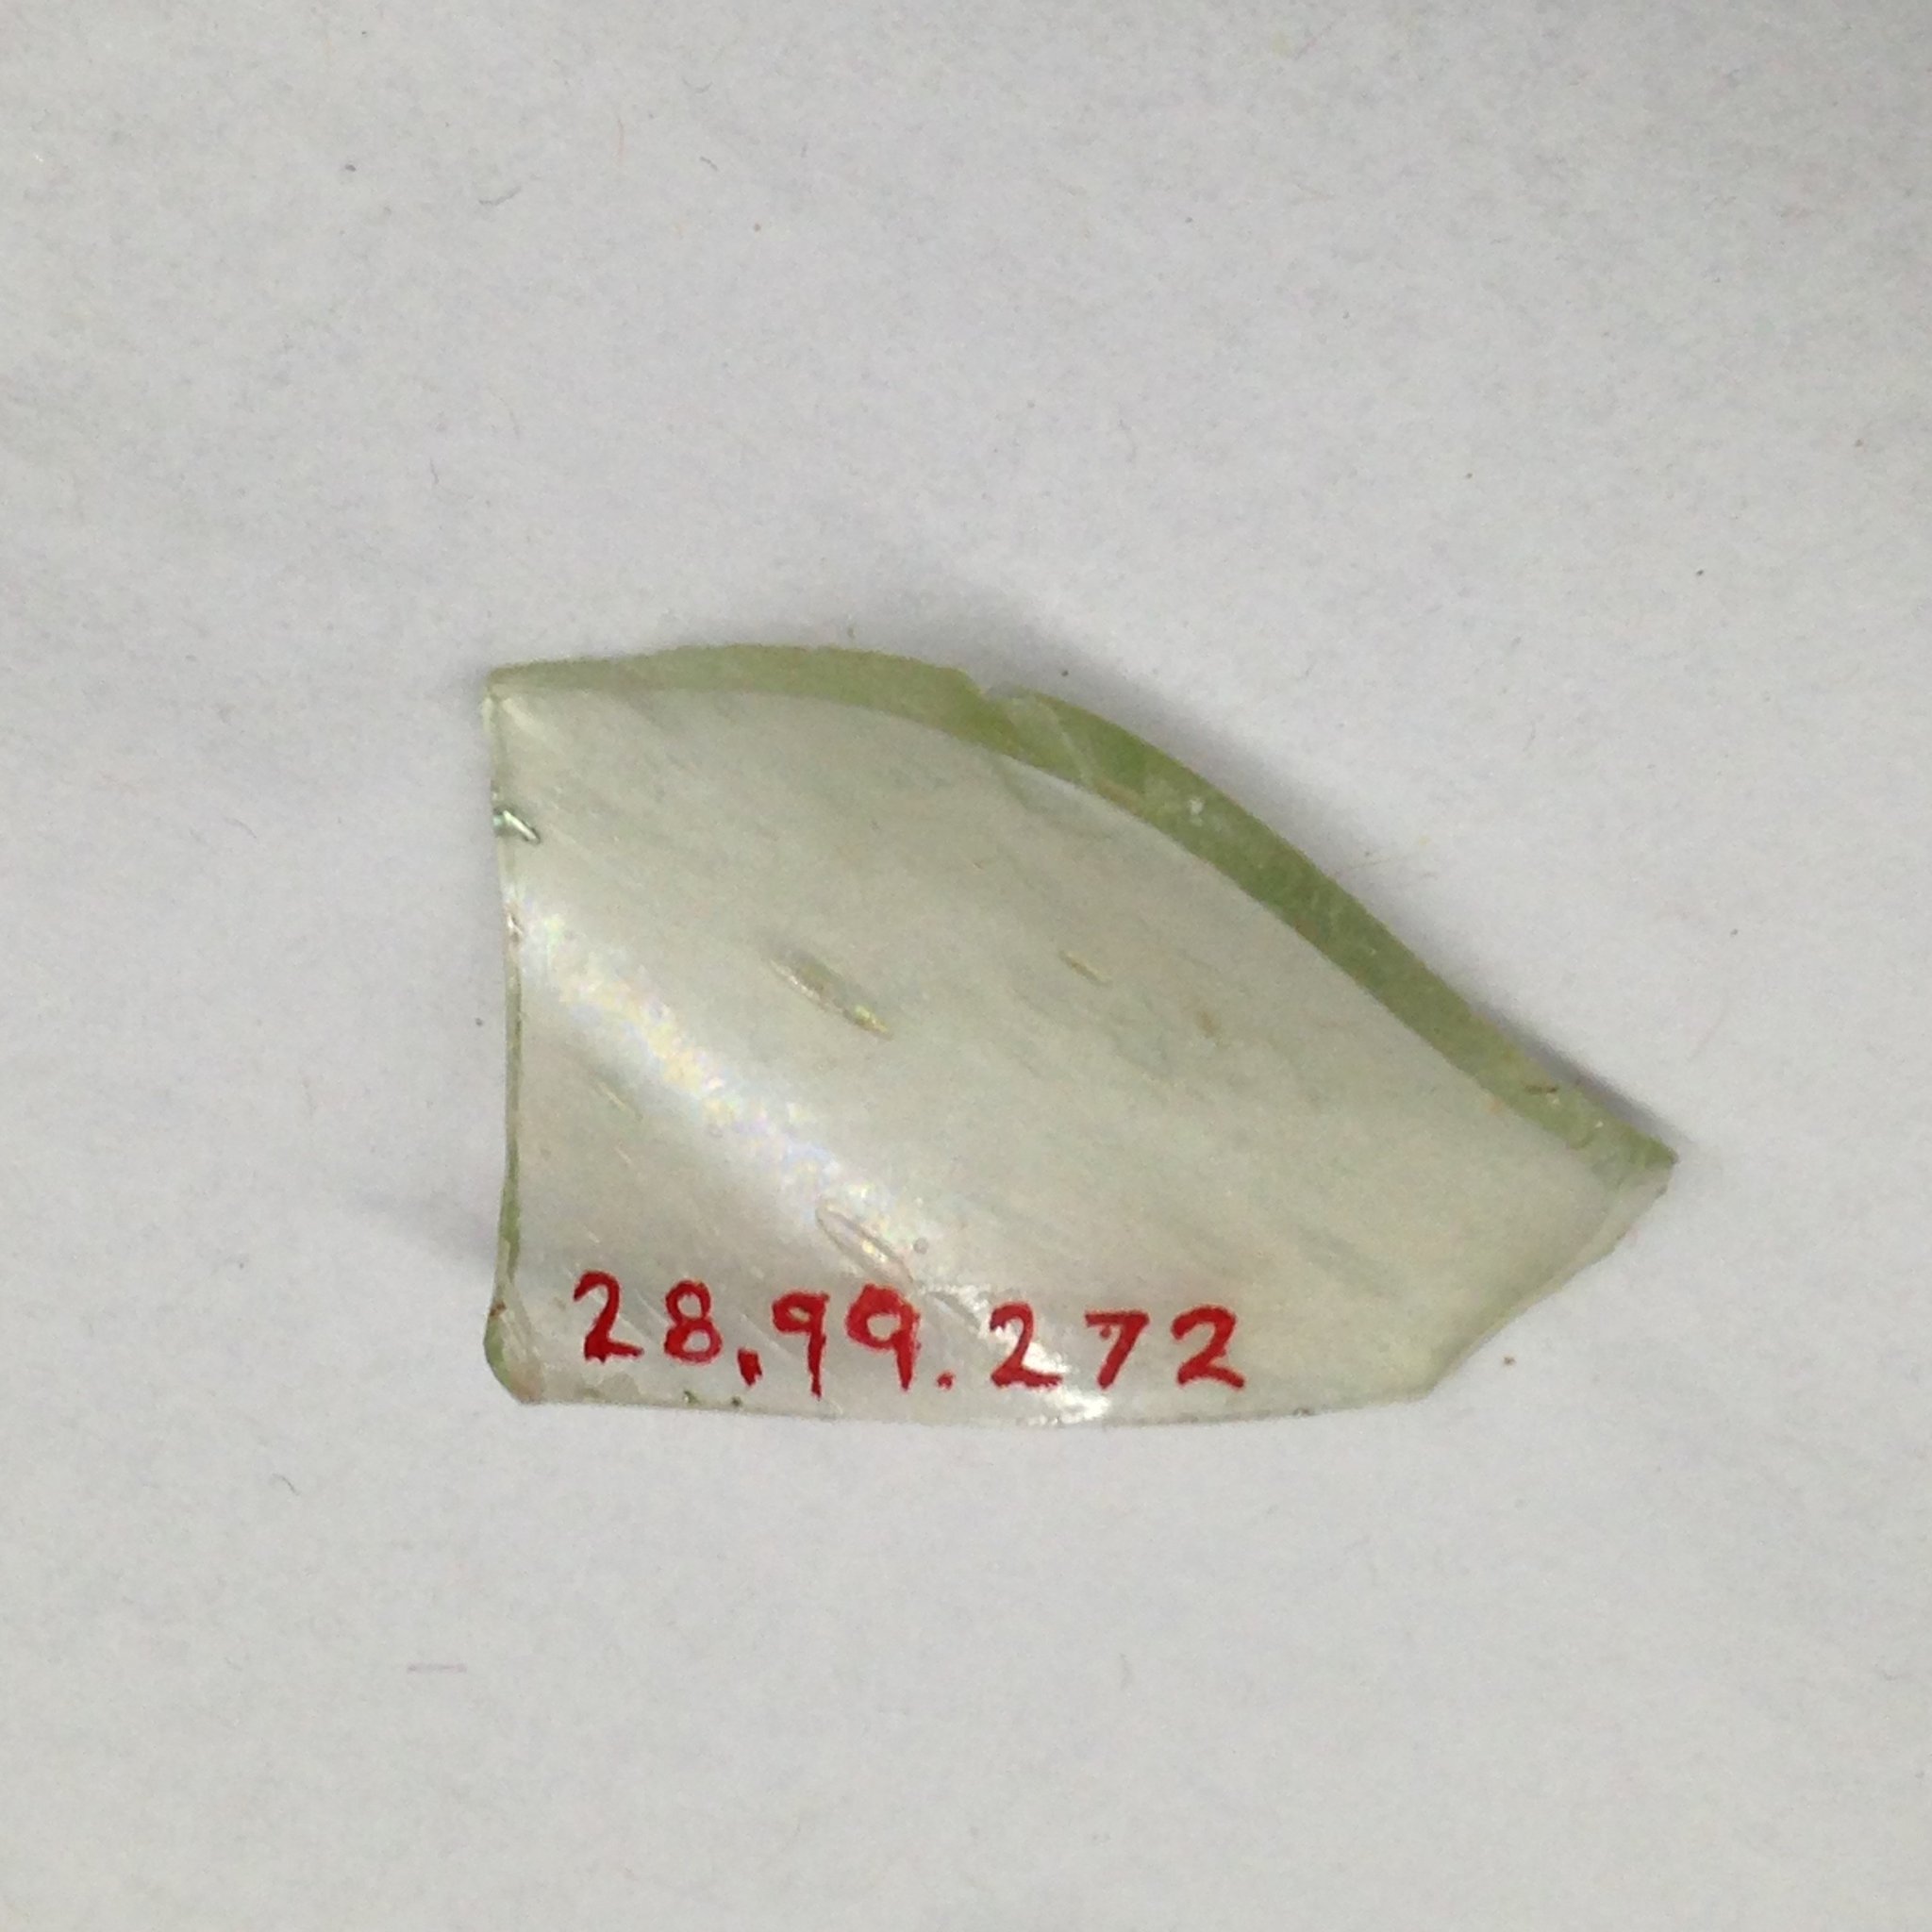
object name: fragment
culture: european or middle eastern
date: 1150-1250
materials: ceramic, glass